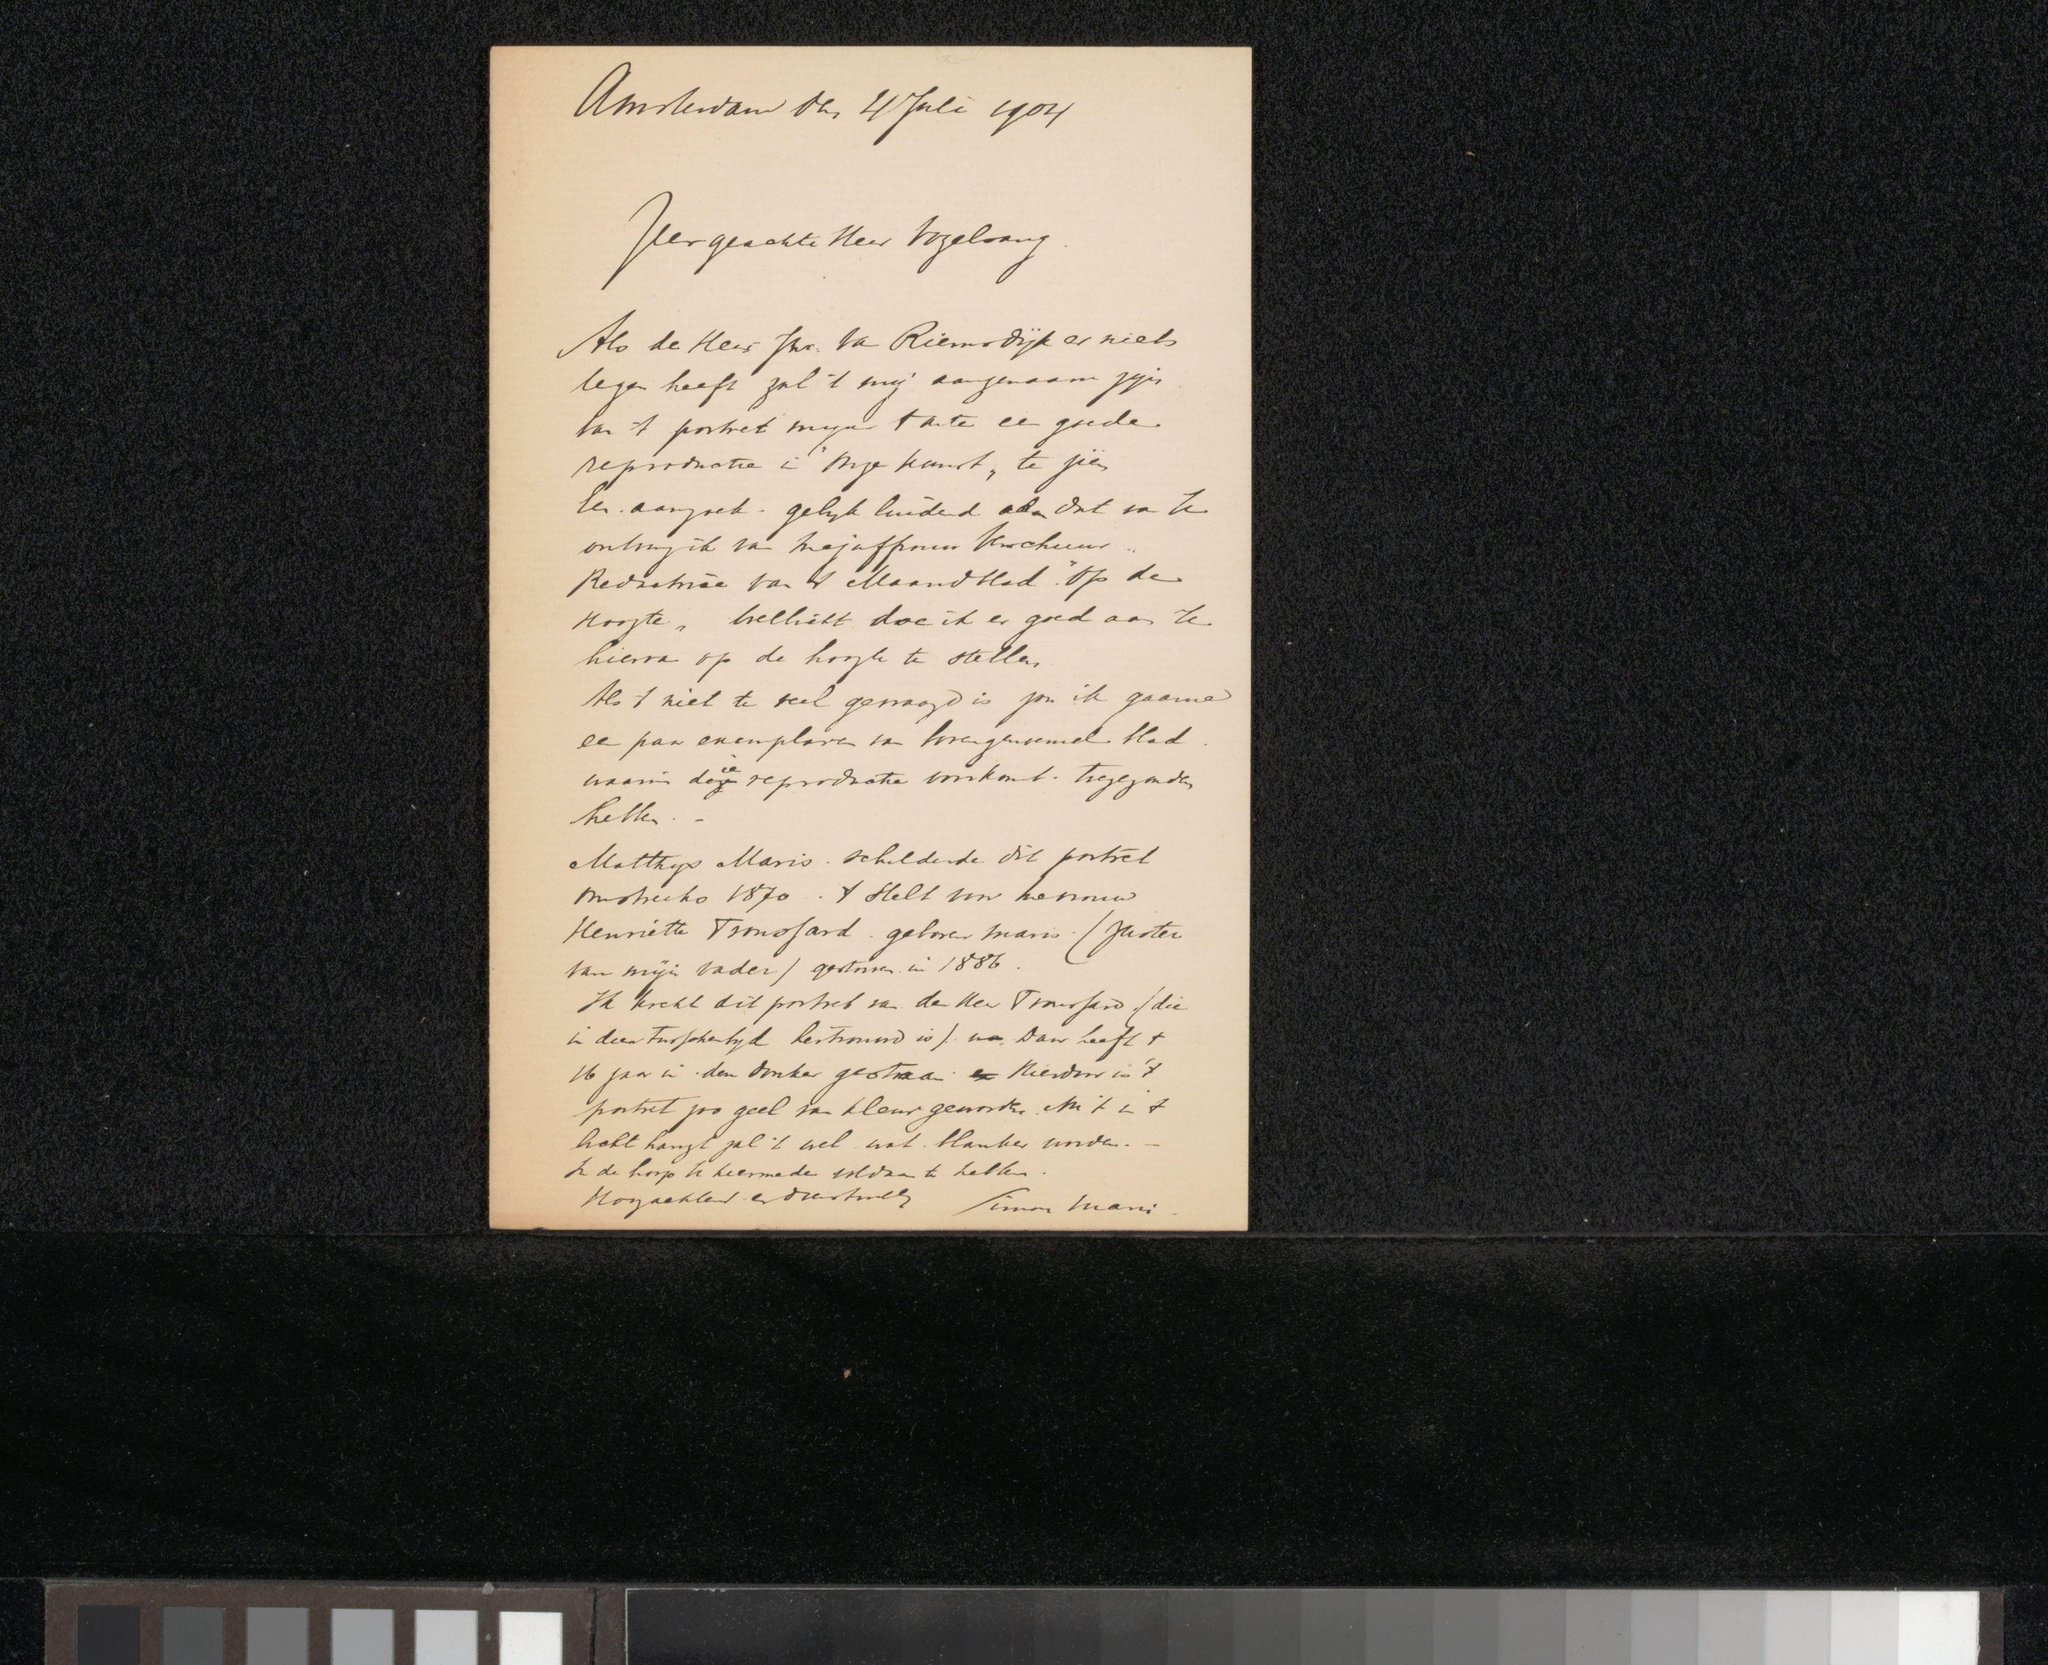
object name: letter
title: Brief aan Willem Vogelsang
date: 1904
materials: ink, paper, pencil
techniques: pen, writing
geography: amsterdam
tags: print maker, matthijs maris, maastricht, engineer, jonkheer barthold willem floris van riemsdijk, leiden, utrecht, draughtsman, willem vogelsang, painting (including book-illumination, miniature-painting), historical persons (portraits and scenes from the life)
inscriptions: collector's mark: Lugt 2228